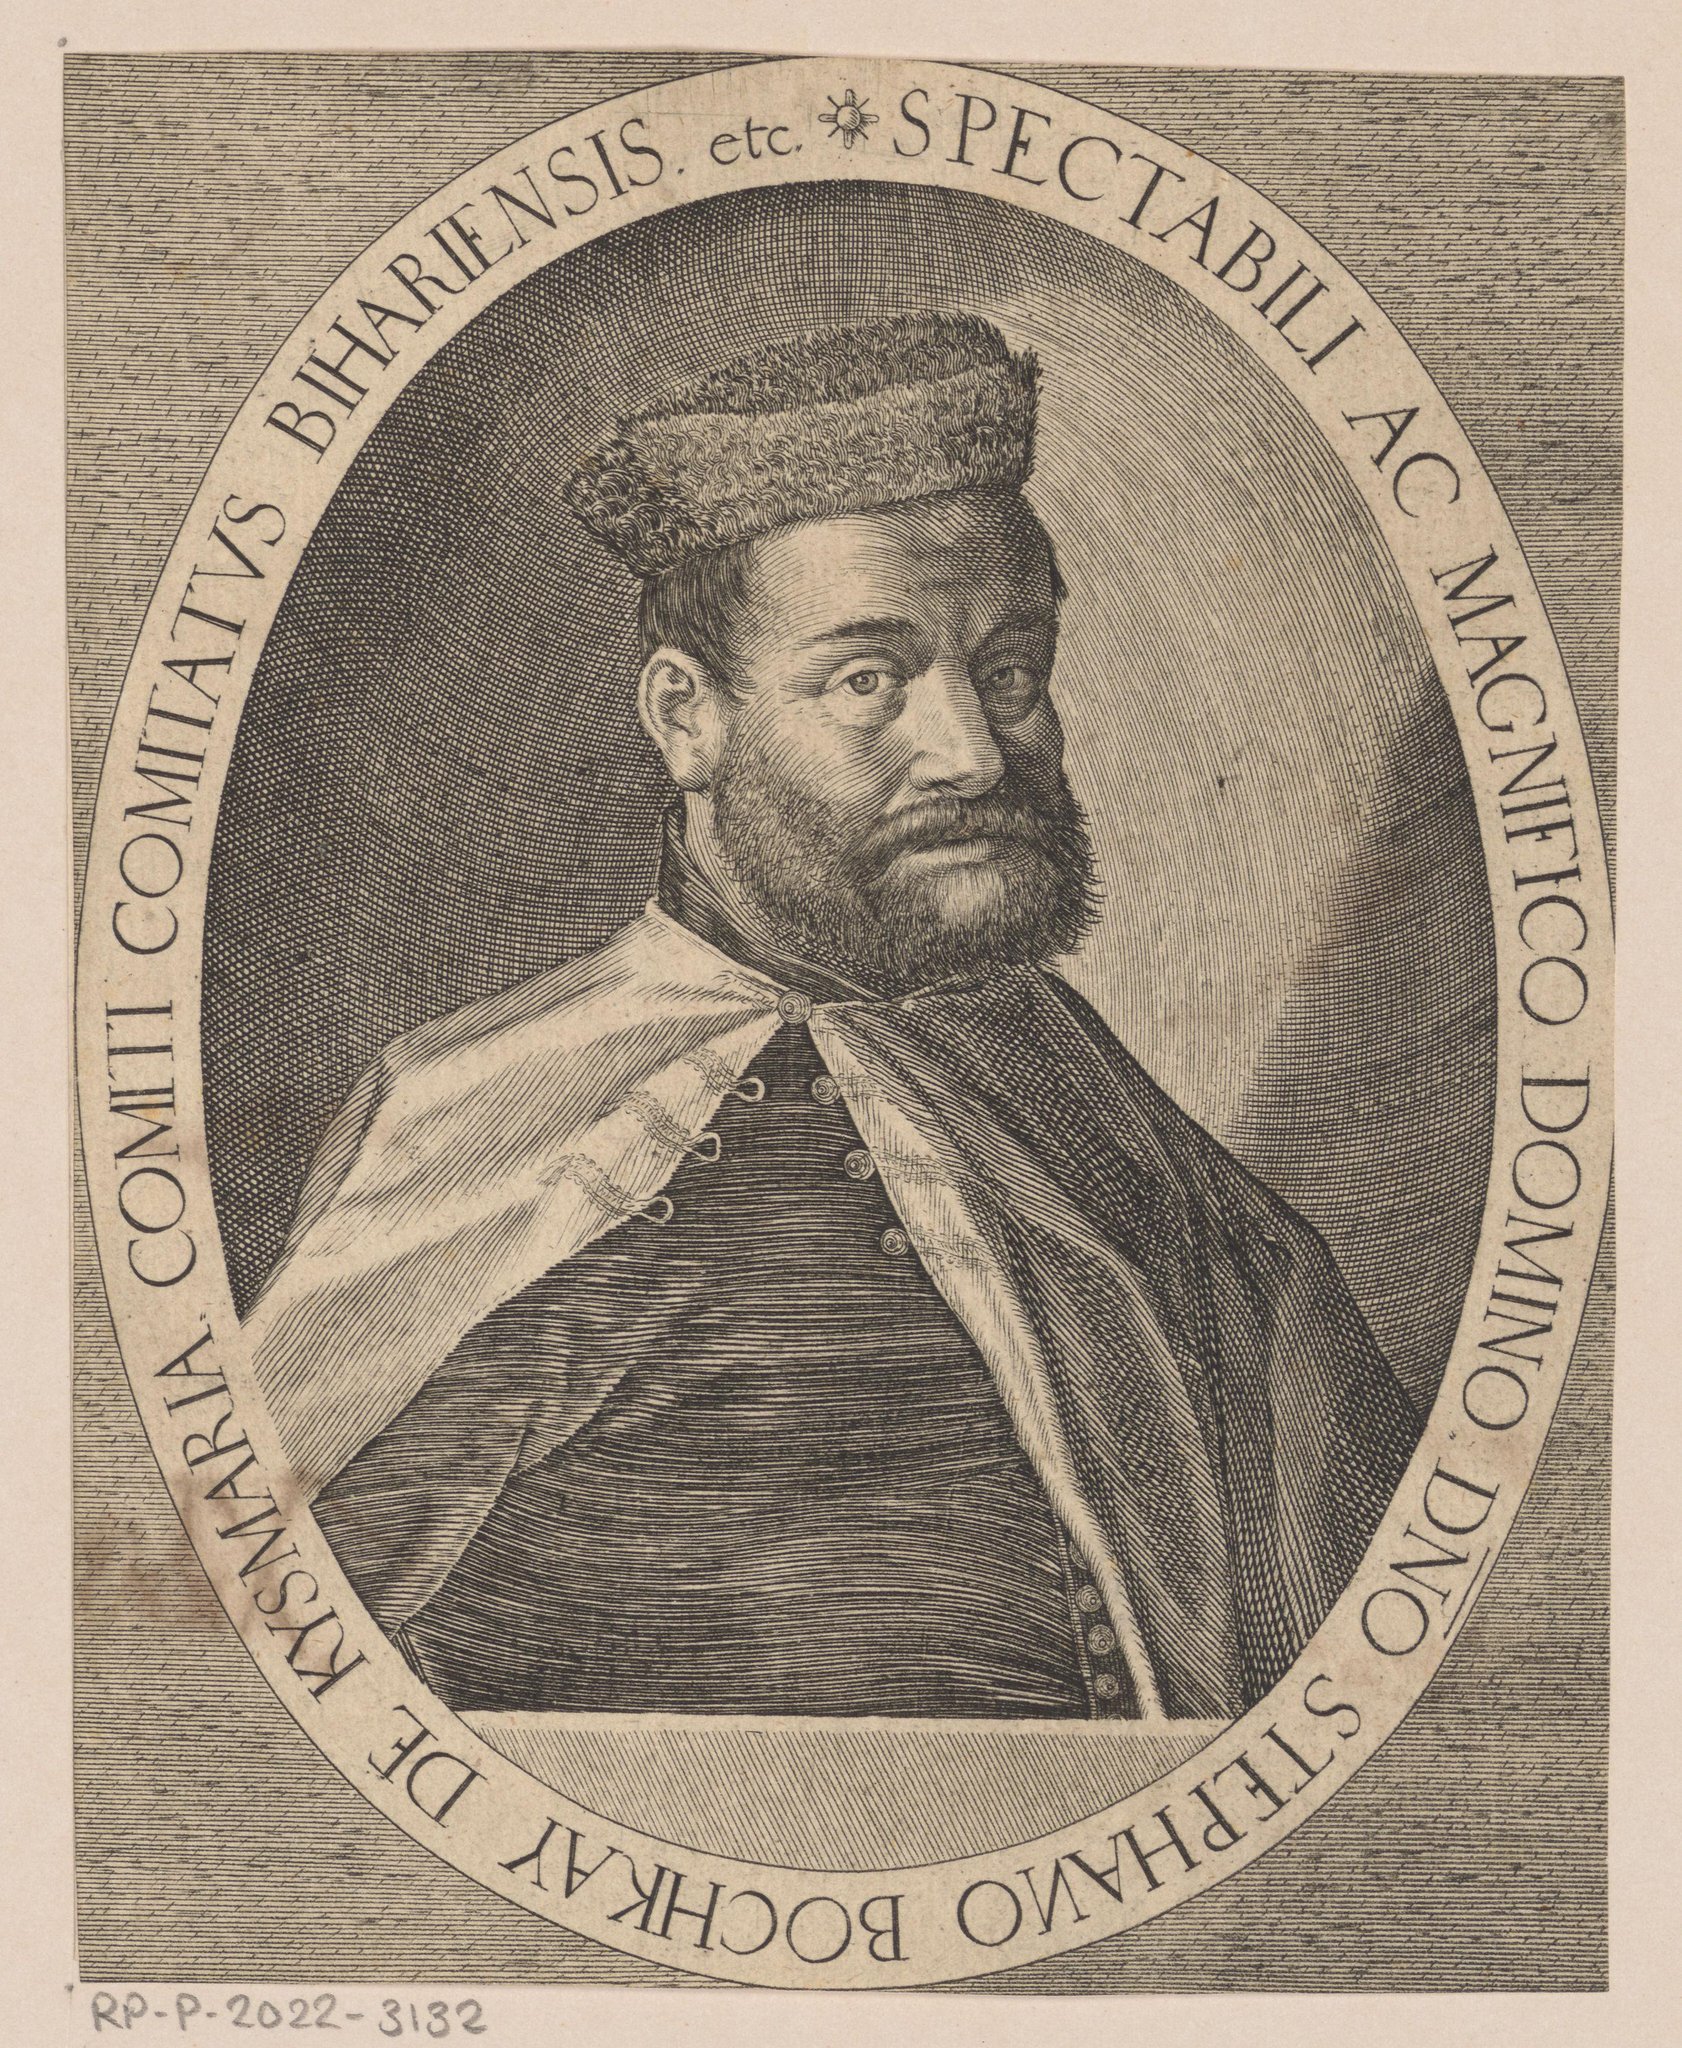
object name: print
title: Portret van István Bocskai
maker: Anonymous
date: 1600-1699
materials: paper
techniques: engraving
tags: prince, historical persons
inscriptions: collector's mark: Lugt 2228, collector's mark: Lugt 240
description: Met tekst in het Latijn rondom het portret.